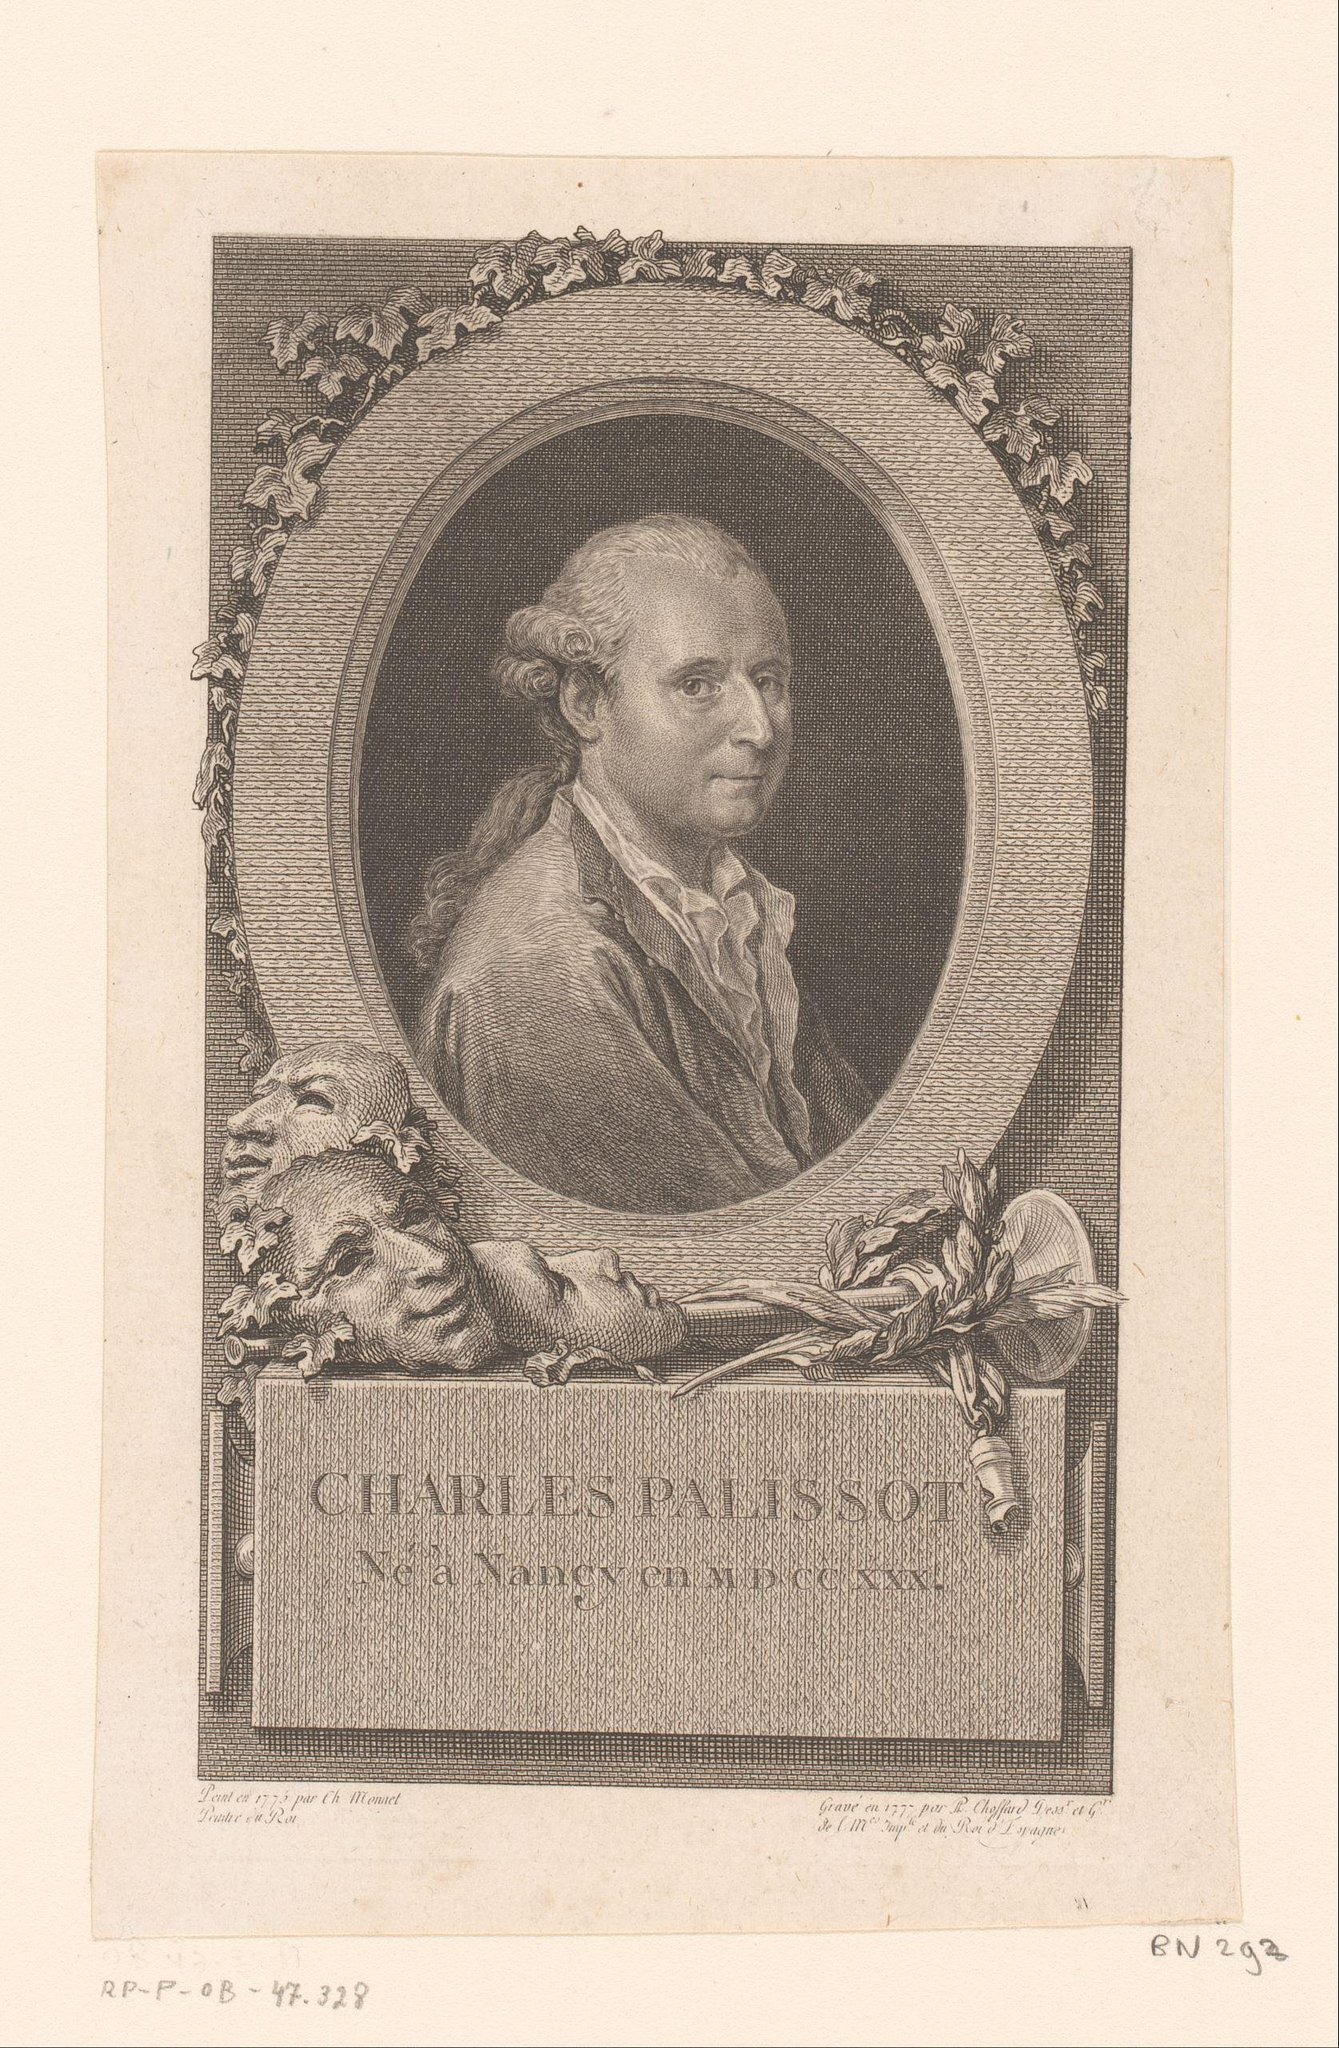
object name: print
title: Portret van Charles Palissot de Montenoy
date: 1777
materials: paper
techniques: engraving, etching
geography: france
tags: ornament ~ medallion, historical persons, mask, mascaron ~ ornament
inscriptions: collector's mark: Lugt 2228